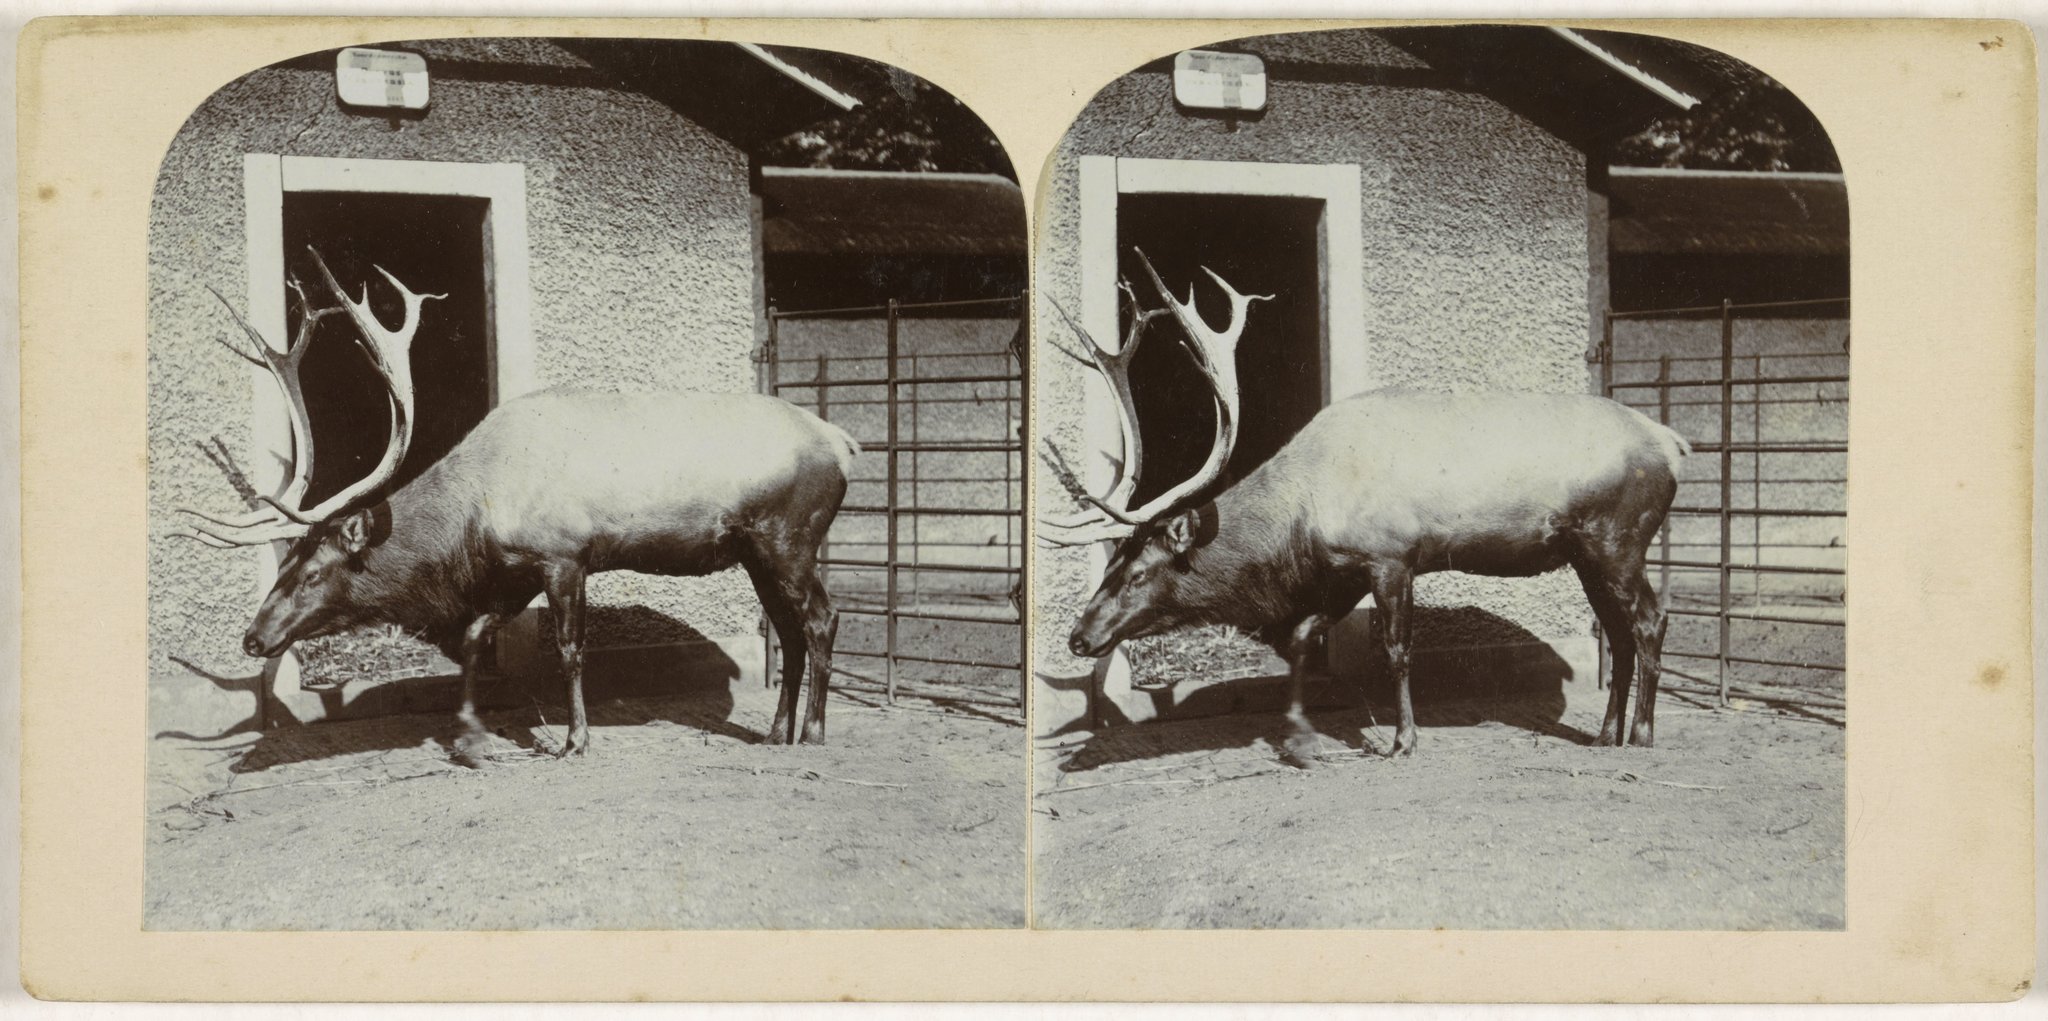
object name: stereograph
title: Rendier in dierentuin (Artis?), Nederland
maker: august frederik willem vogt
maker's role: fotograaf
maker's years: 1871-1922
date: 1920-1940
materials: cardboard, paper, photographic support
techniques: collodion silver print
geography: netherlands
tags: netherlands